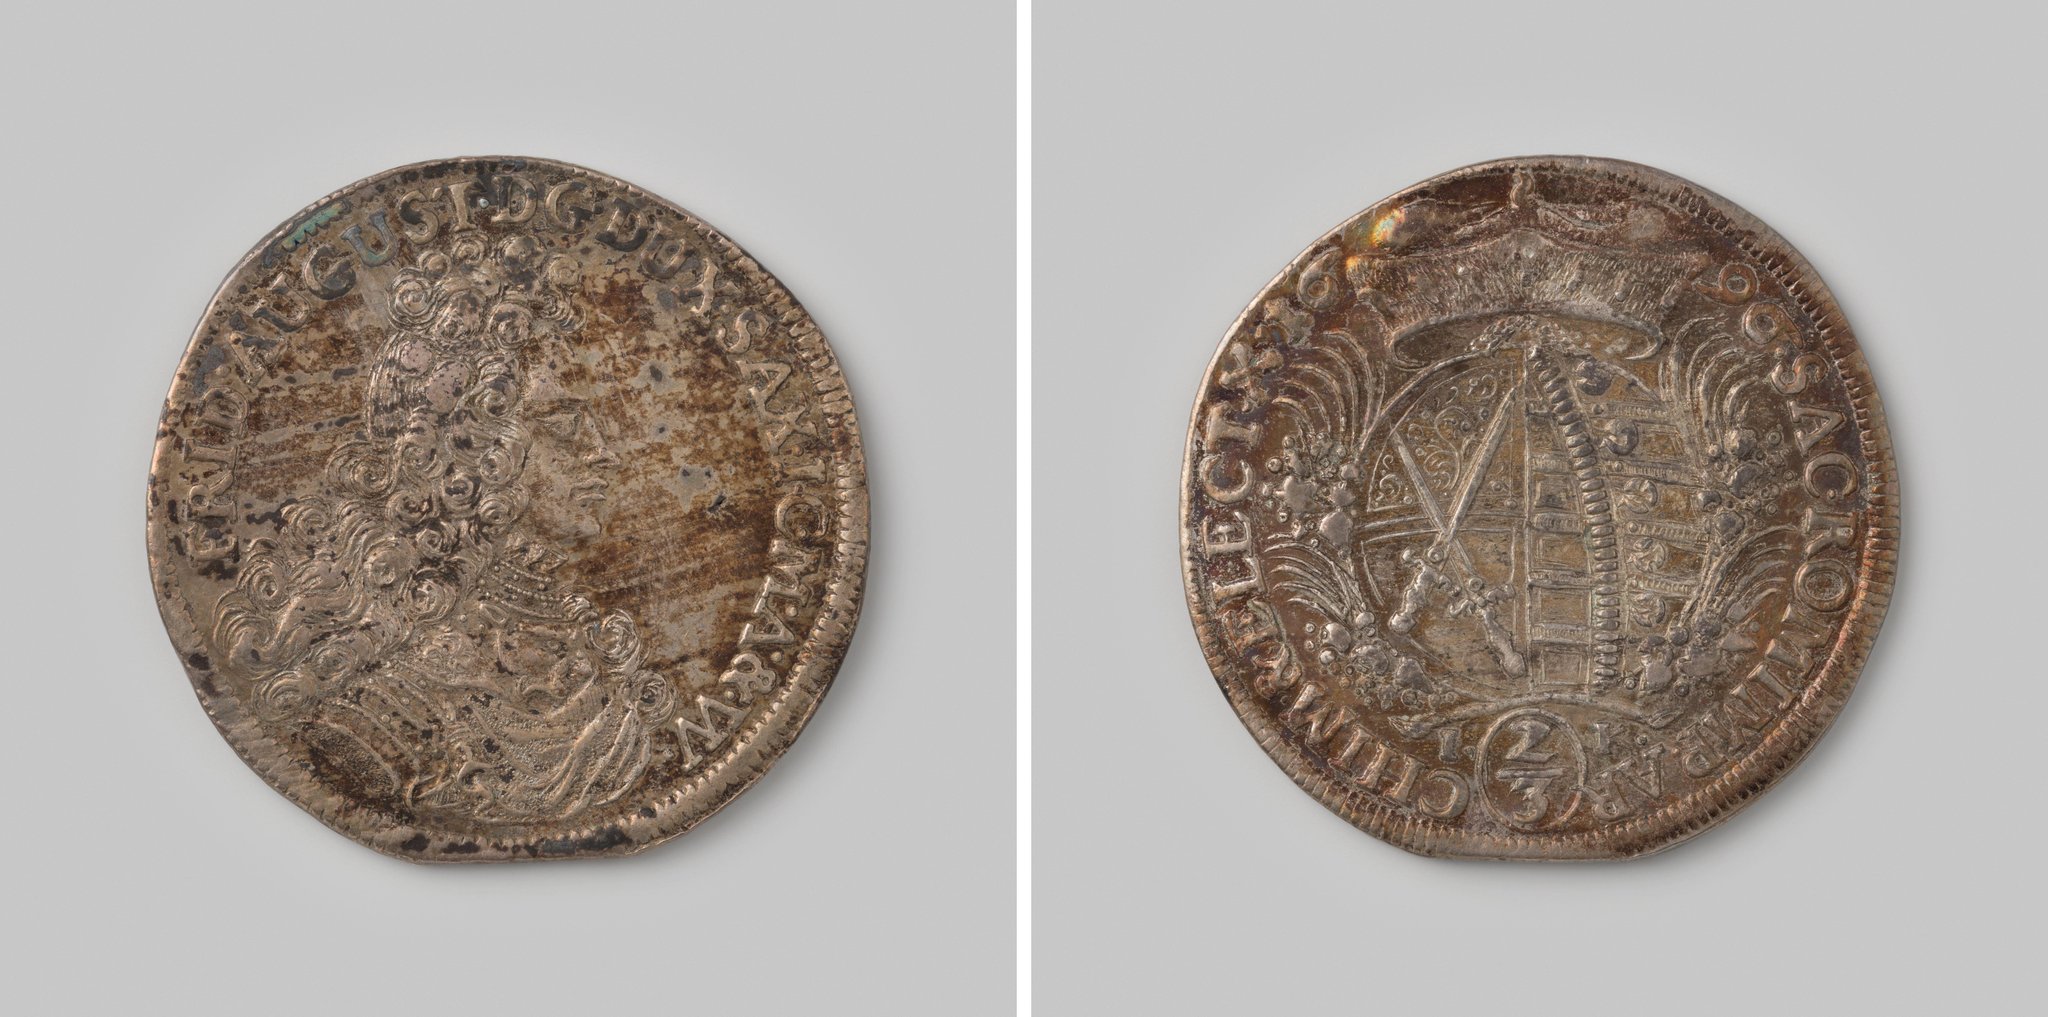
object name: tweederde taler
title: Saksen, Albertinische Linie, Friedrich August I, 2/3 taler,1696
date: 1696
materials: silver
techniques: striking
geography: leipzig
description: Zilveren munt. Voorzijde: portret van de keurvorst naar rechts. Keerzijde: Versierd samengesteld wapenschild, waarop keurvorstenhoed. Daaronder in ovaal schild waarde-aanduiding. Jaartal rondom hoed bovenaan.